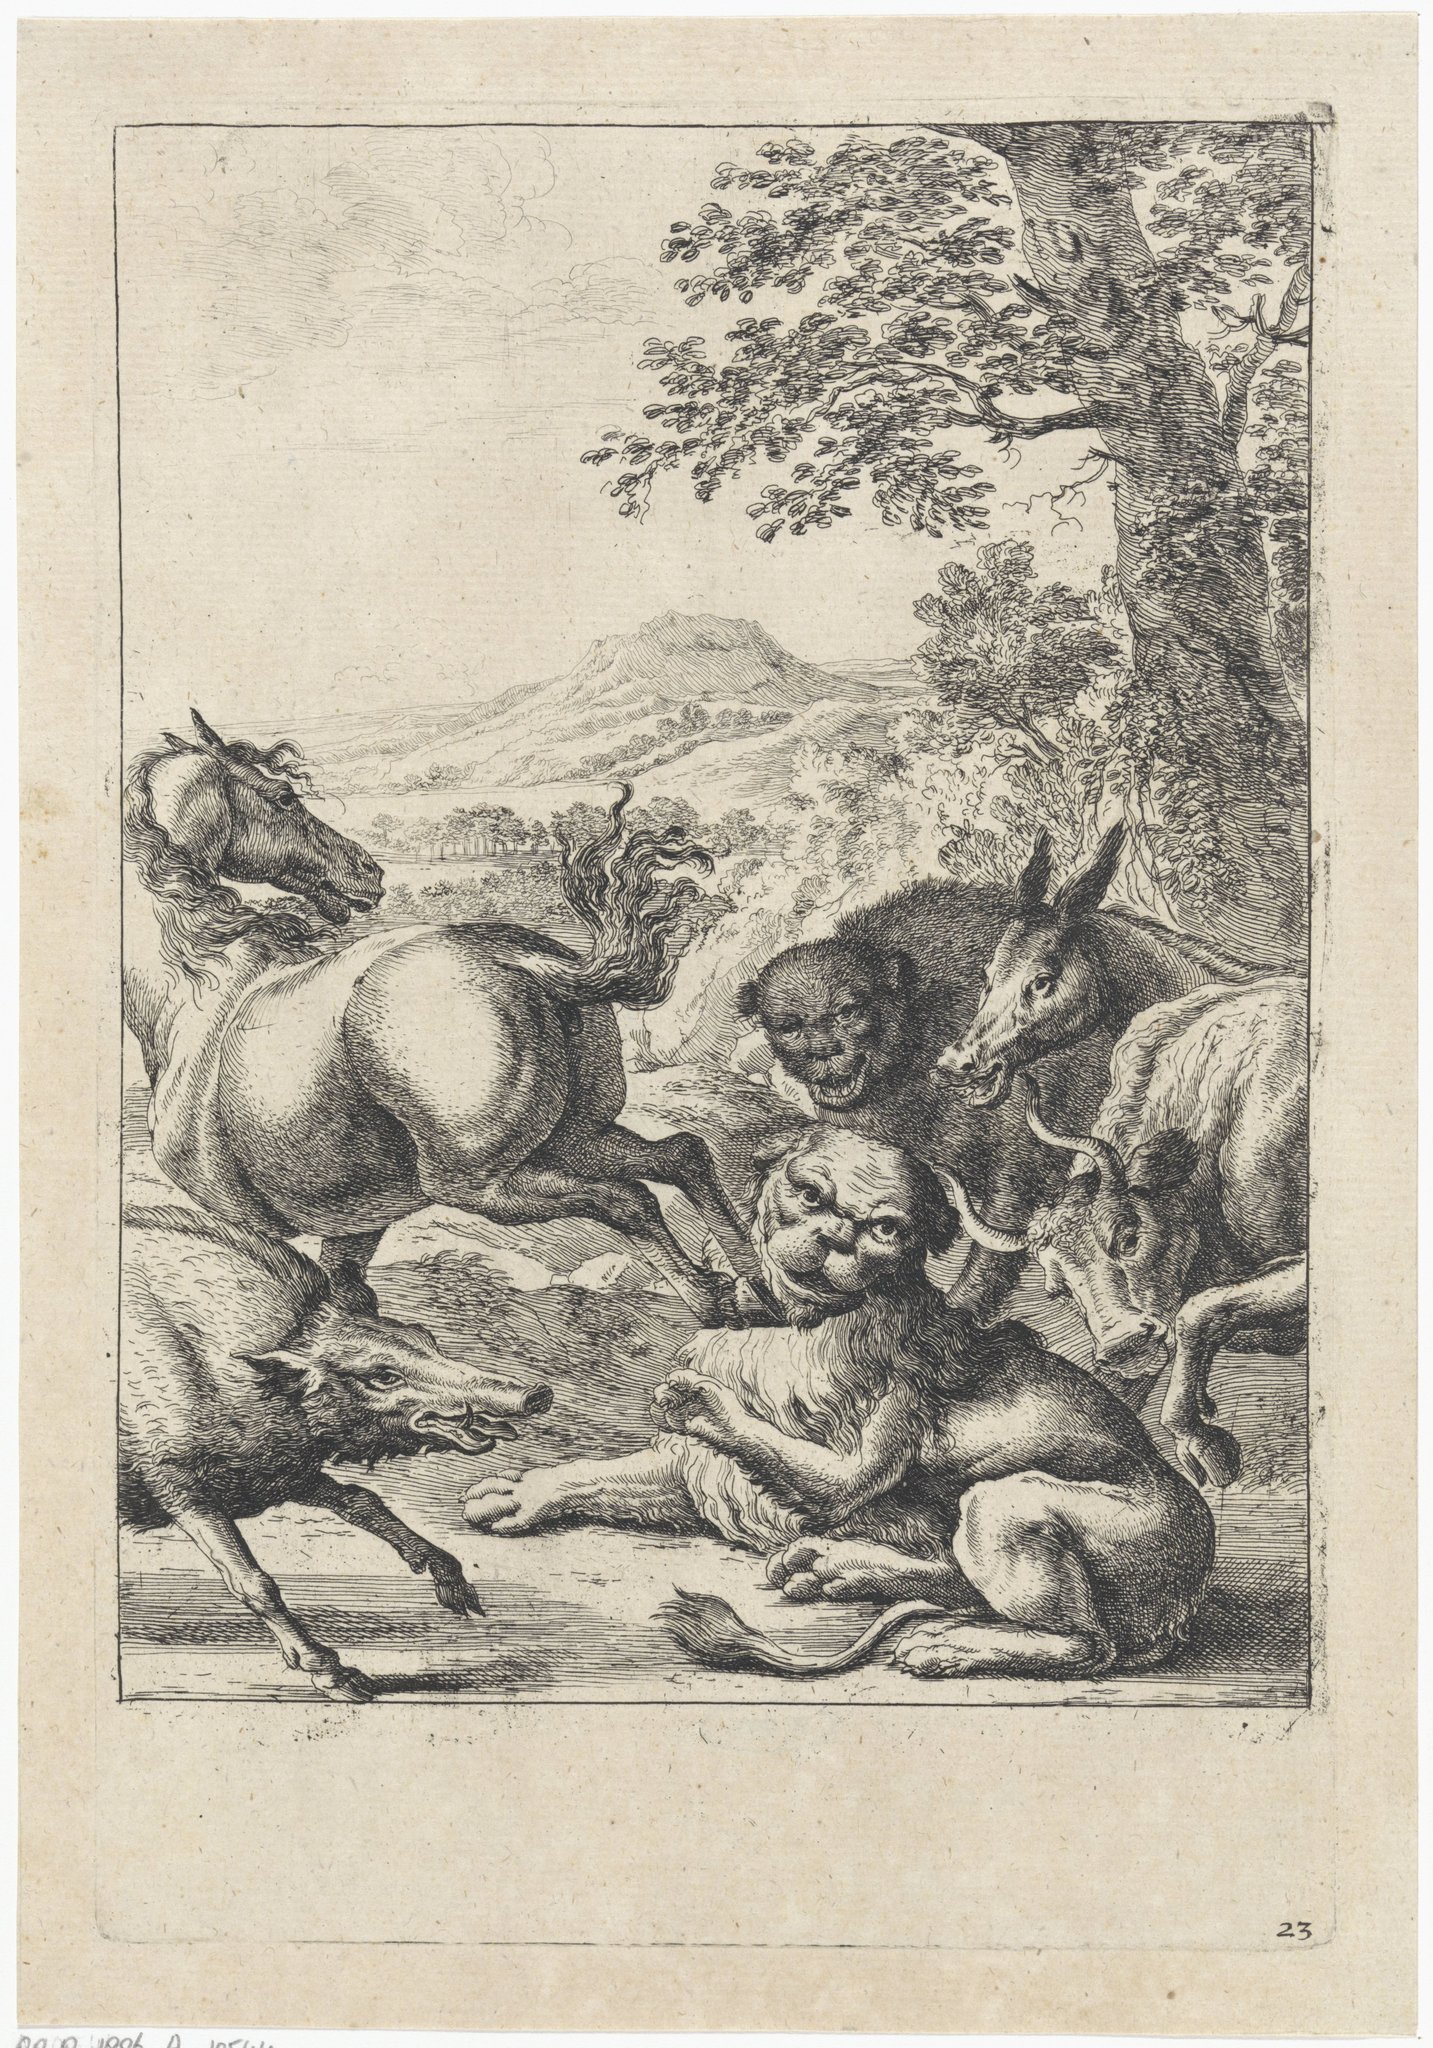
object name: book illustration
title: Fabels van Aesopus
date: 1665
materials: paper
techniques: etching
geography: london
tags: bull, ass, donkey, hoofed animals: boar, beasts of prey, predatory animals: bear, fables, horse, beasts of prey, predatory animals: lion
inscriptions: collector's mark: Lugt 2228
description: Een oude leeuw ligt krachteloos en stervend op de grond. Een paard, zwijn, beer, stier en ezel verwonden hem nu ze sterker zijn. Illustratie van een fabel van Aesopus.